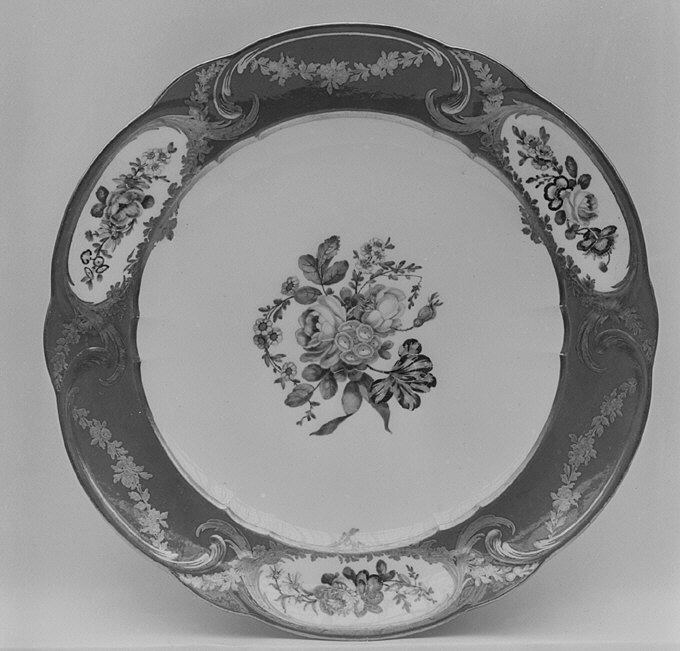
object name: plate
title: Plate (Assiette à palmes) (1 of 102) (part of a service)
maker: sèvres manufactory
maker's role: manufactory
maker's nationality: french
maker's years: 1740-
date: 1772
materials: soft paste porcelain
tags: flowers